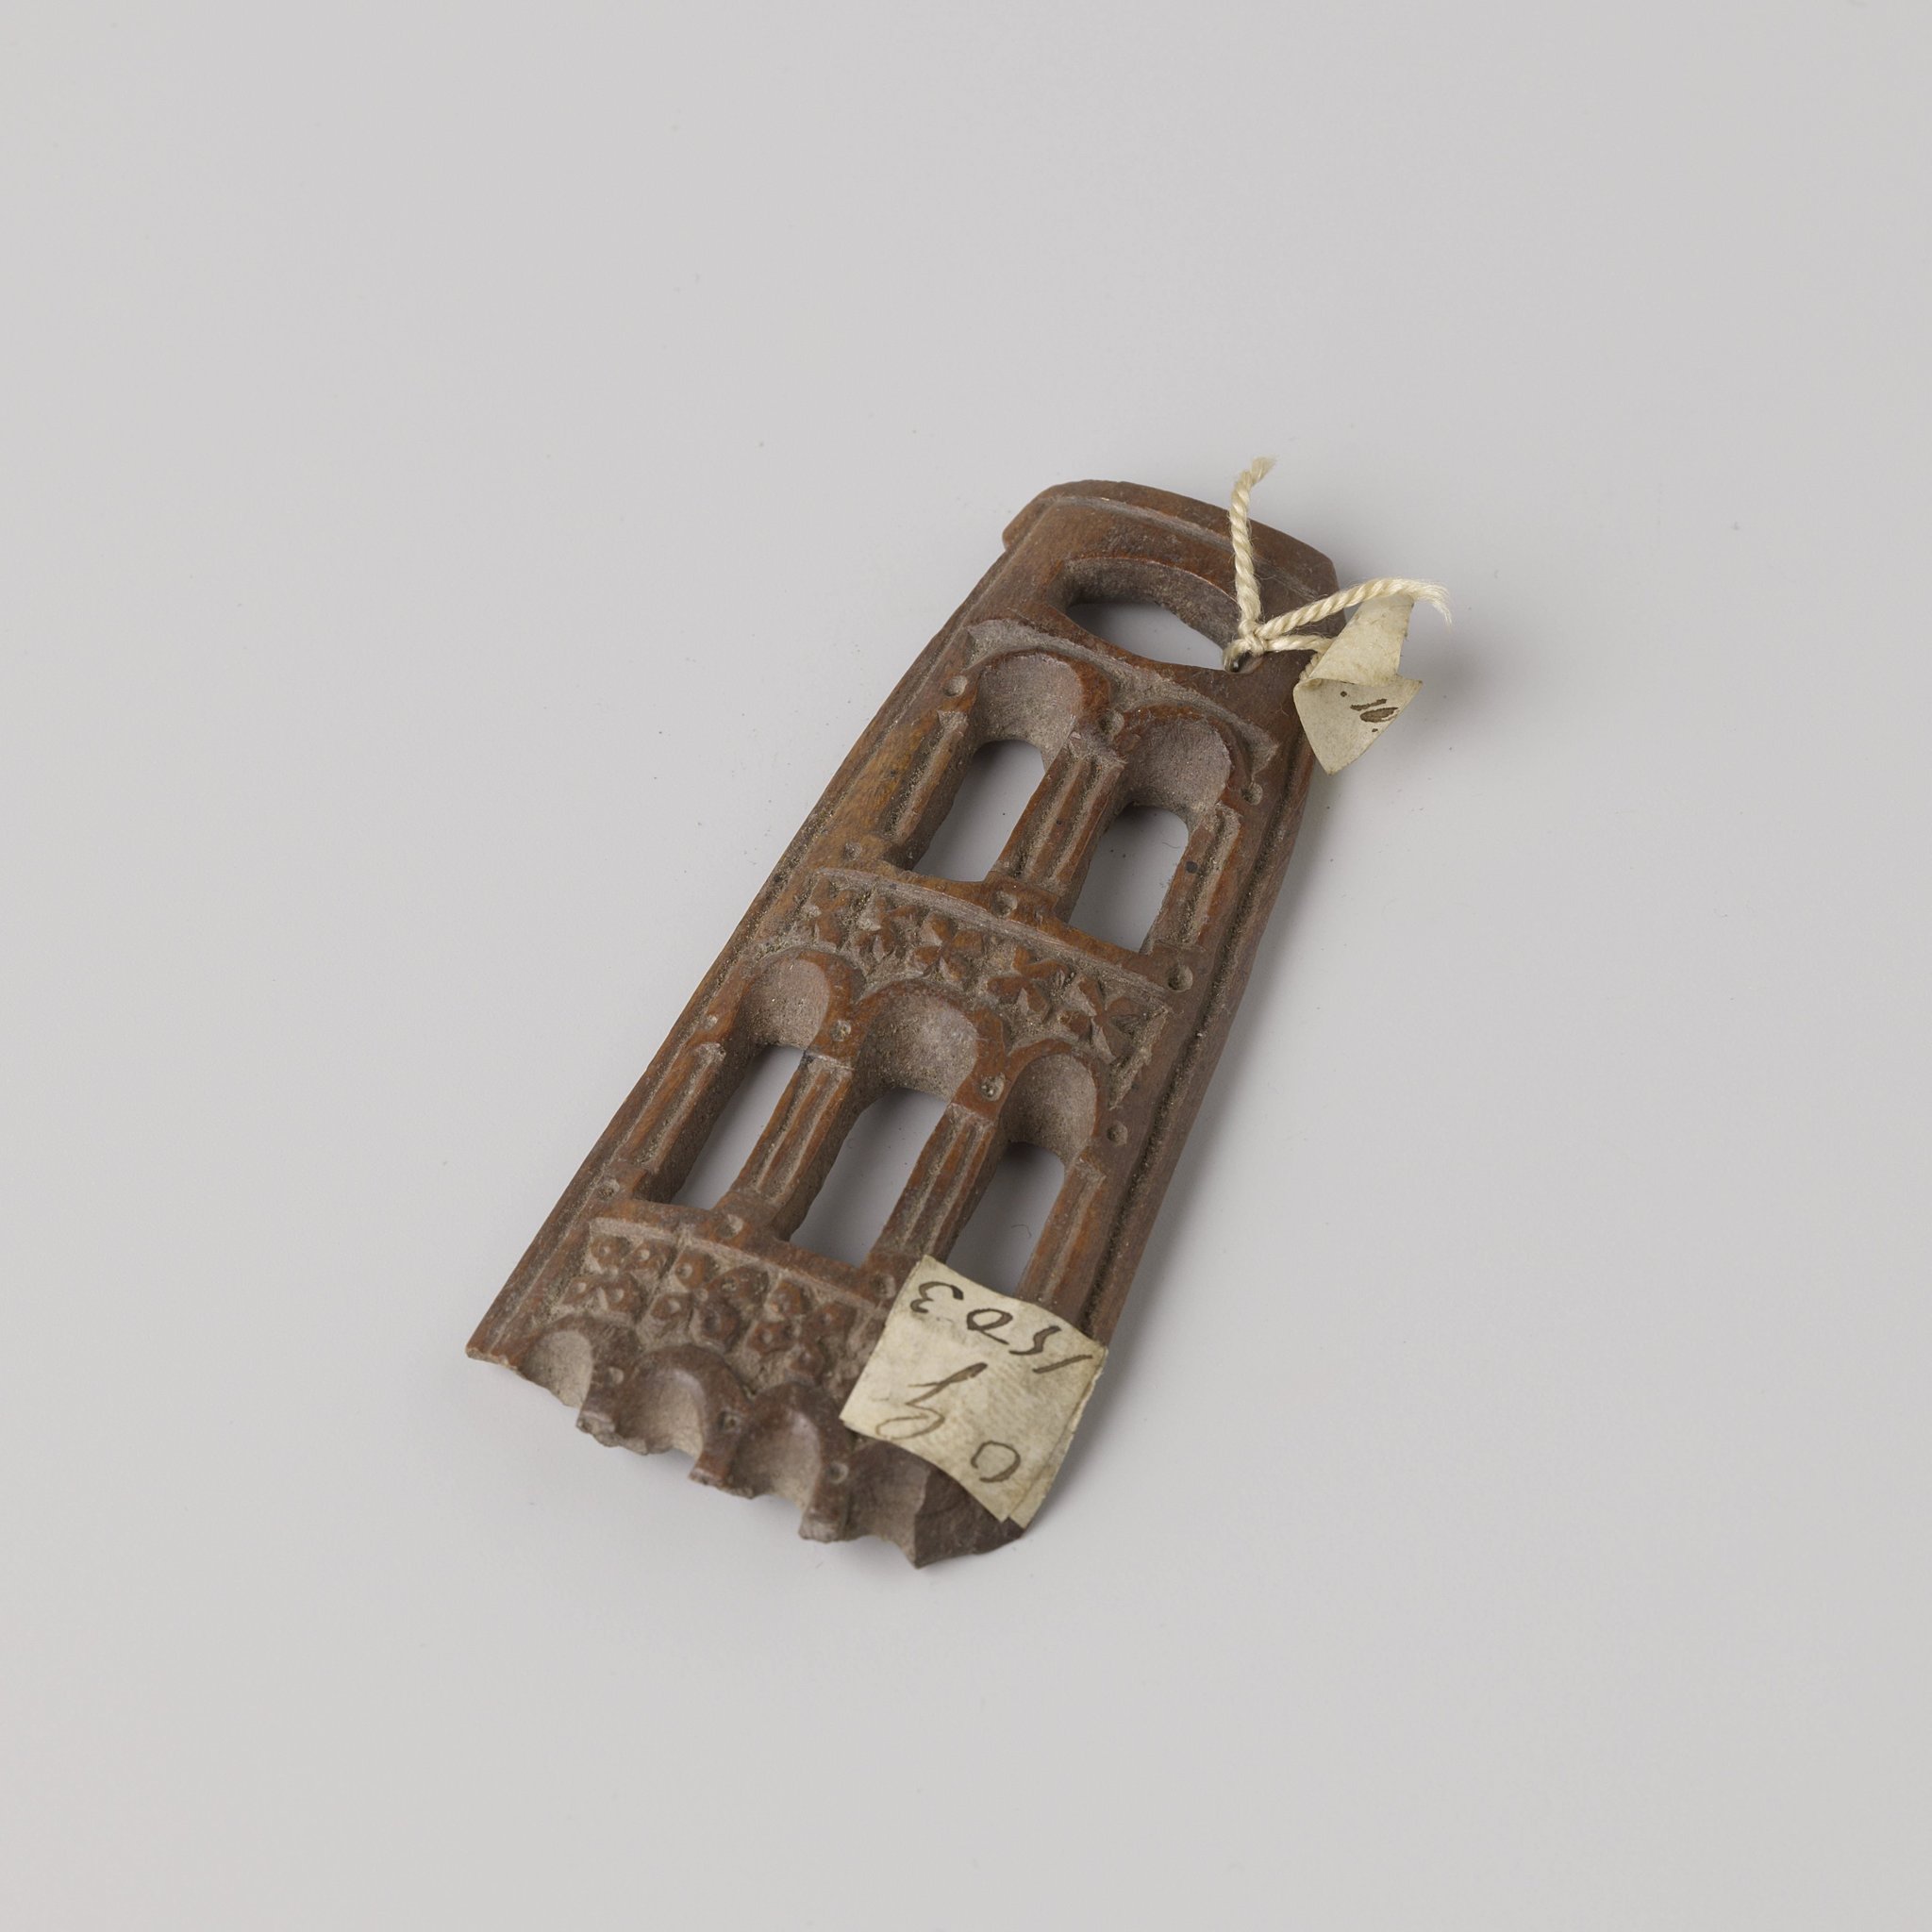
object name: stoelleuning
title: Benen stoelleuning (?)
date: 1200-1800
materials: bone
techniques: cutting, embroidery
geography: netherlands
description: Iets gebold, plat, bruin stuk been, naar één kant smal toelopend. Aan één zijde bewerkt met geometrische motieven en opengewerkt met gaten als ramen met romaanse boog; een rij van twee, daaronder een rij van drie, daaronder de bogen van vier gaten maar daar is het afgebroken. Boven de rij van twee dwarsliggend ellipsvormig gat.